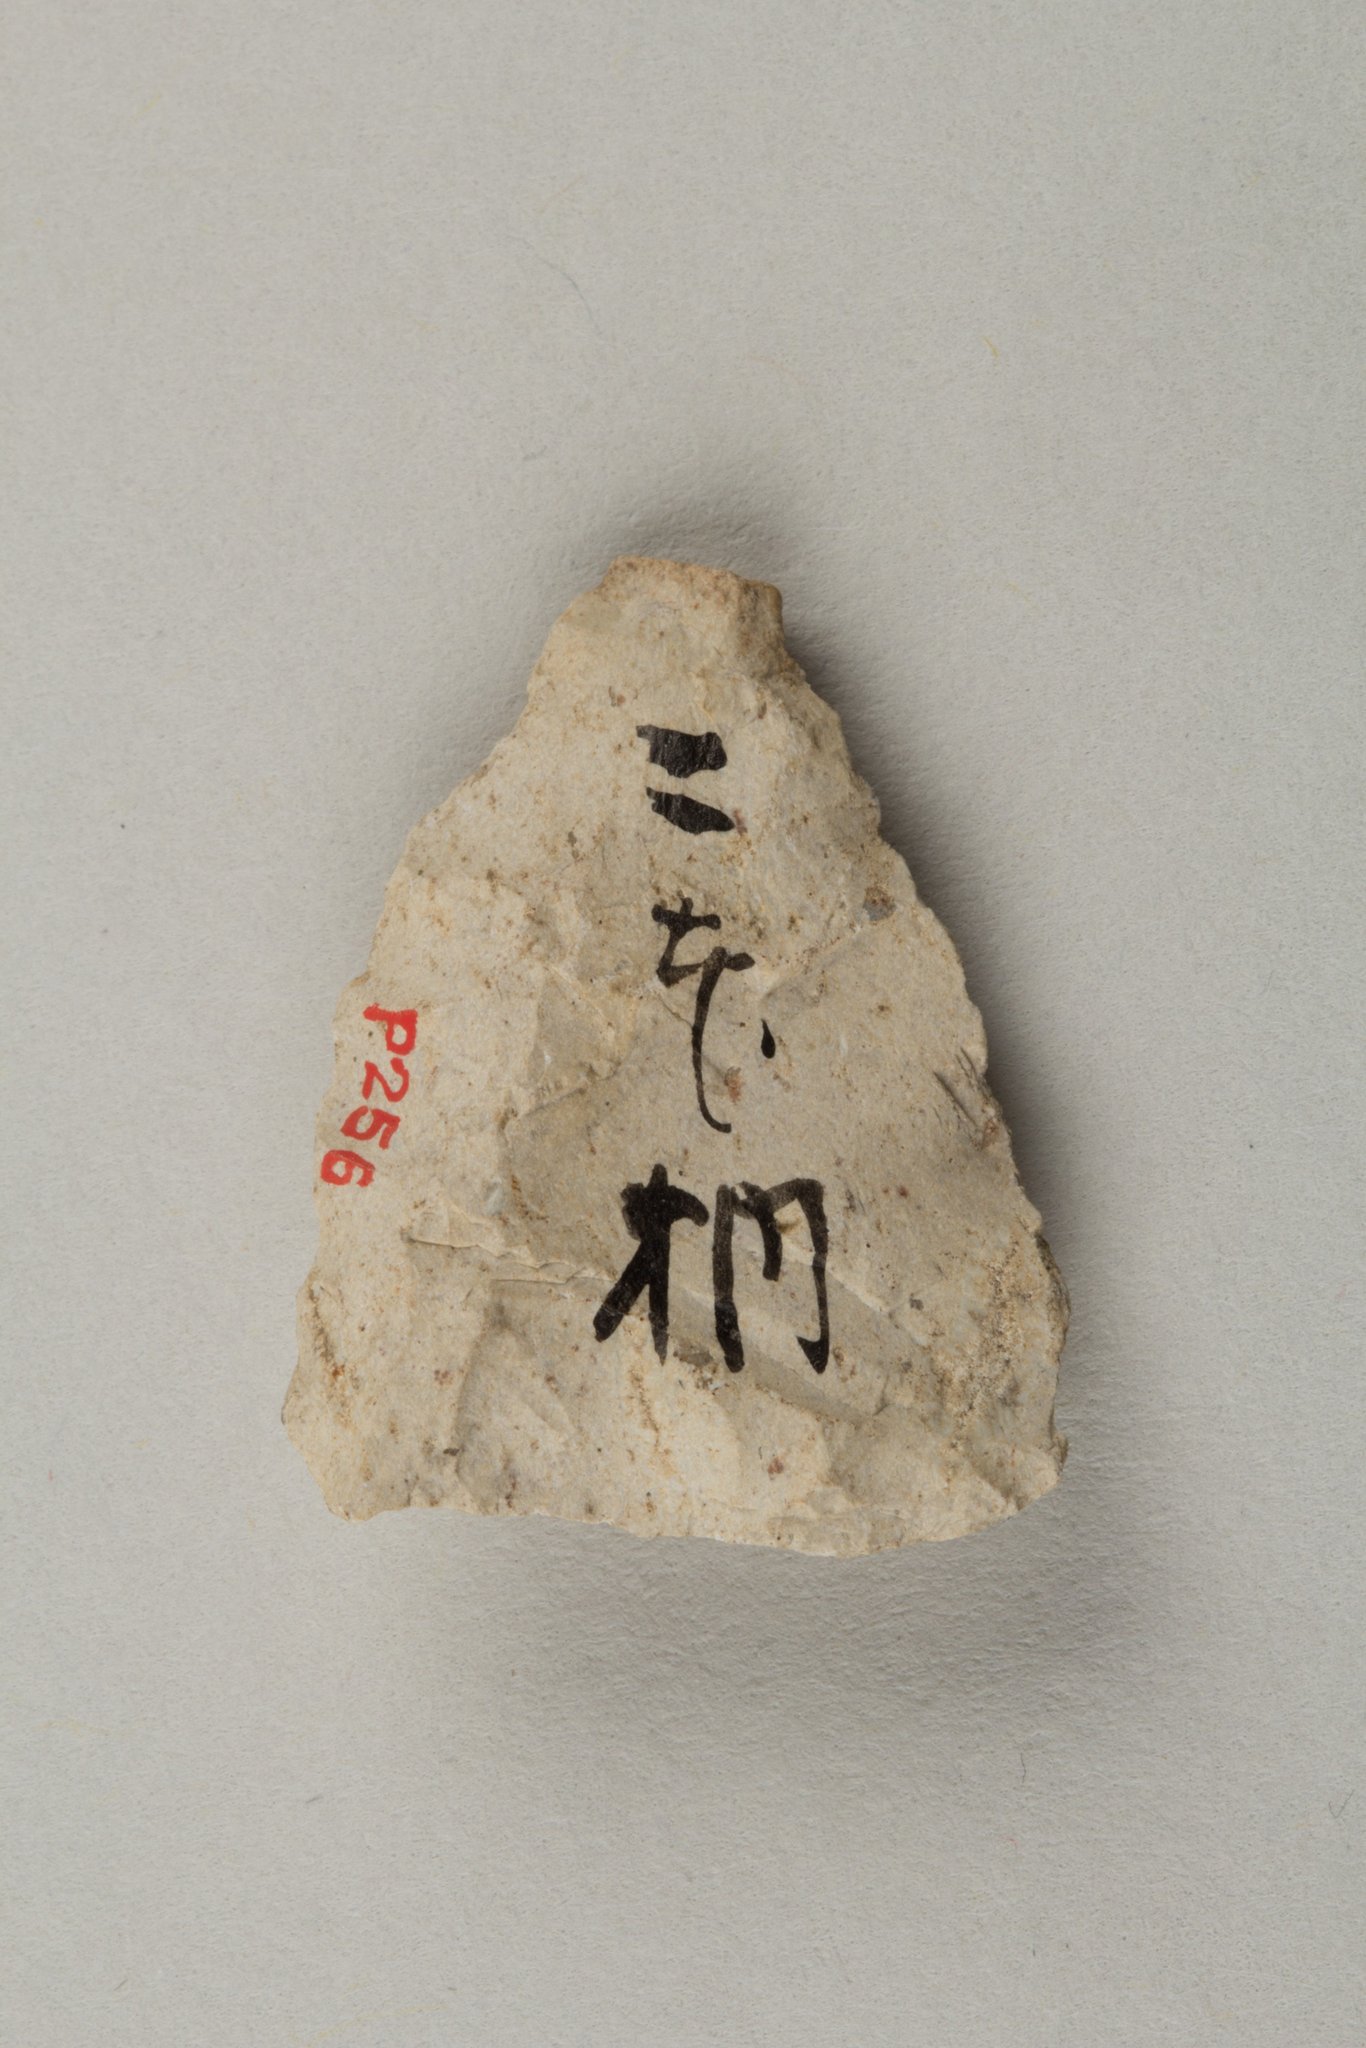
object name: arrowhead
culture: japanese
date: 1500-1000 BCE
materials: stone